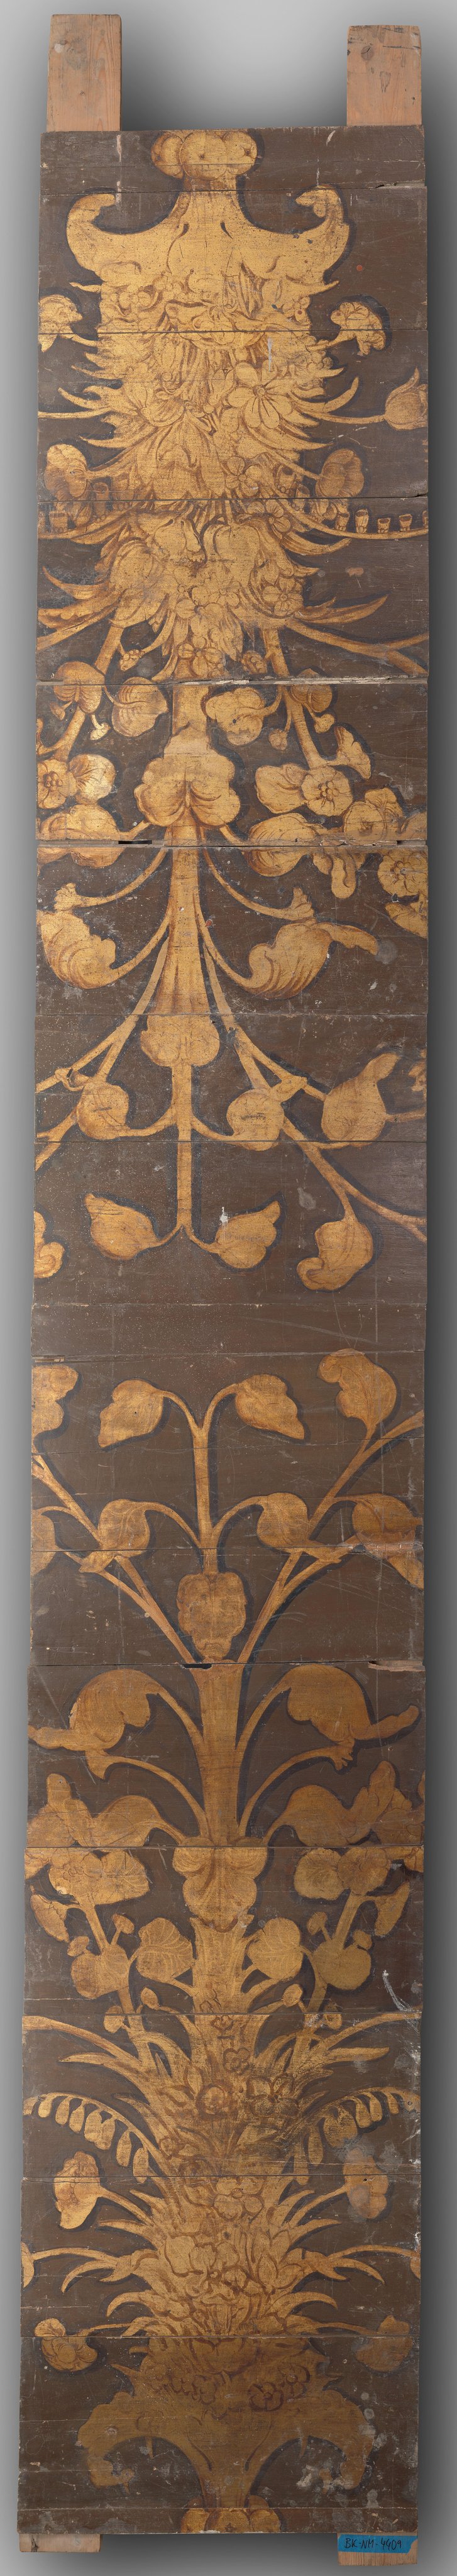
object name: architectural element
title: Tongewelf, samengesteld uit eiken planken, beschilderd met grotesken en acanthusranken, afgewende vrouwenfiguren met onderlijven die eindigen in klauwen en voluten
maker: Anonymous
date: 1600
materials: wood, paint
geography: northern netherlands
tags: the hague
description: Gewelf bestaande uit ongeveer 150 panelen van verschillende grootte. Onderdelen 194 t/m 199, onderdelen 24 t/m 30, onderdelen 31 t/m 35, onderdelen 177 t/m 183, onderdelen 200 t/m 207, onderdelen 208 t/m 213 en onderdelen 36 t/m 43.